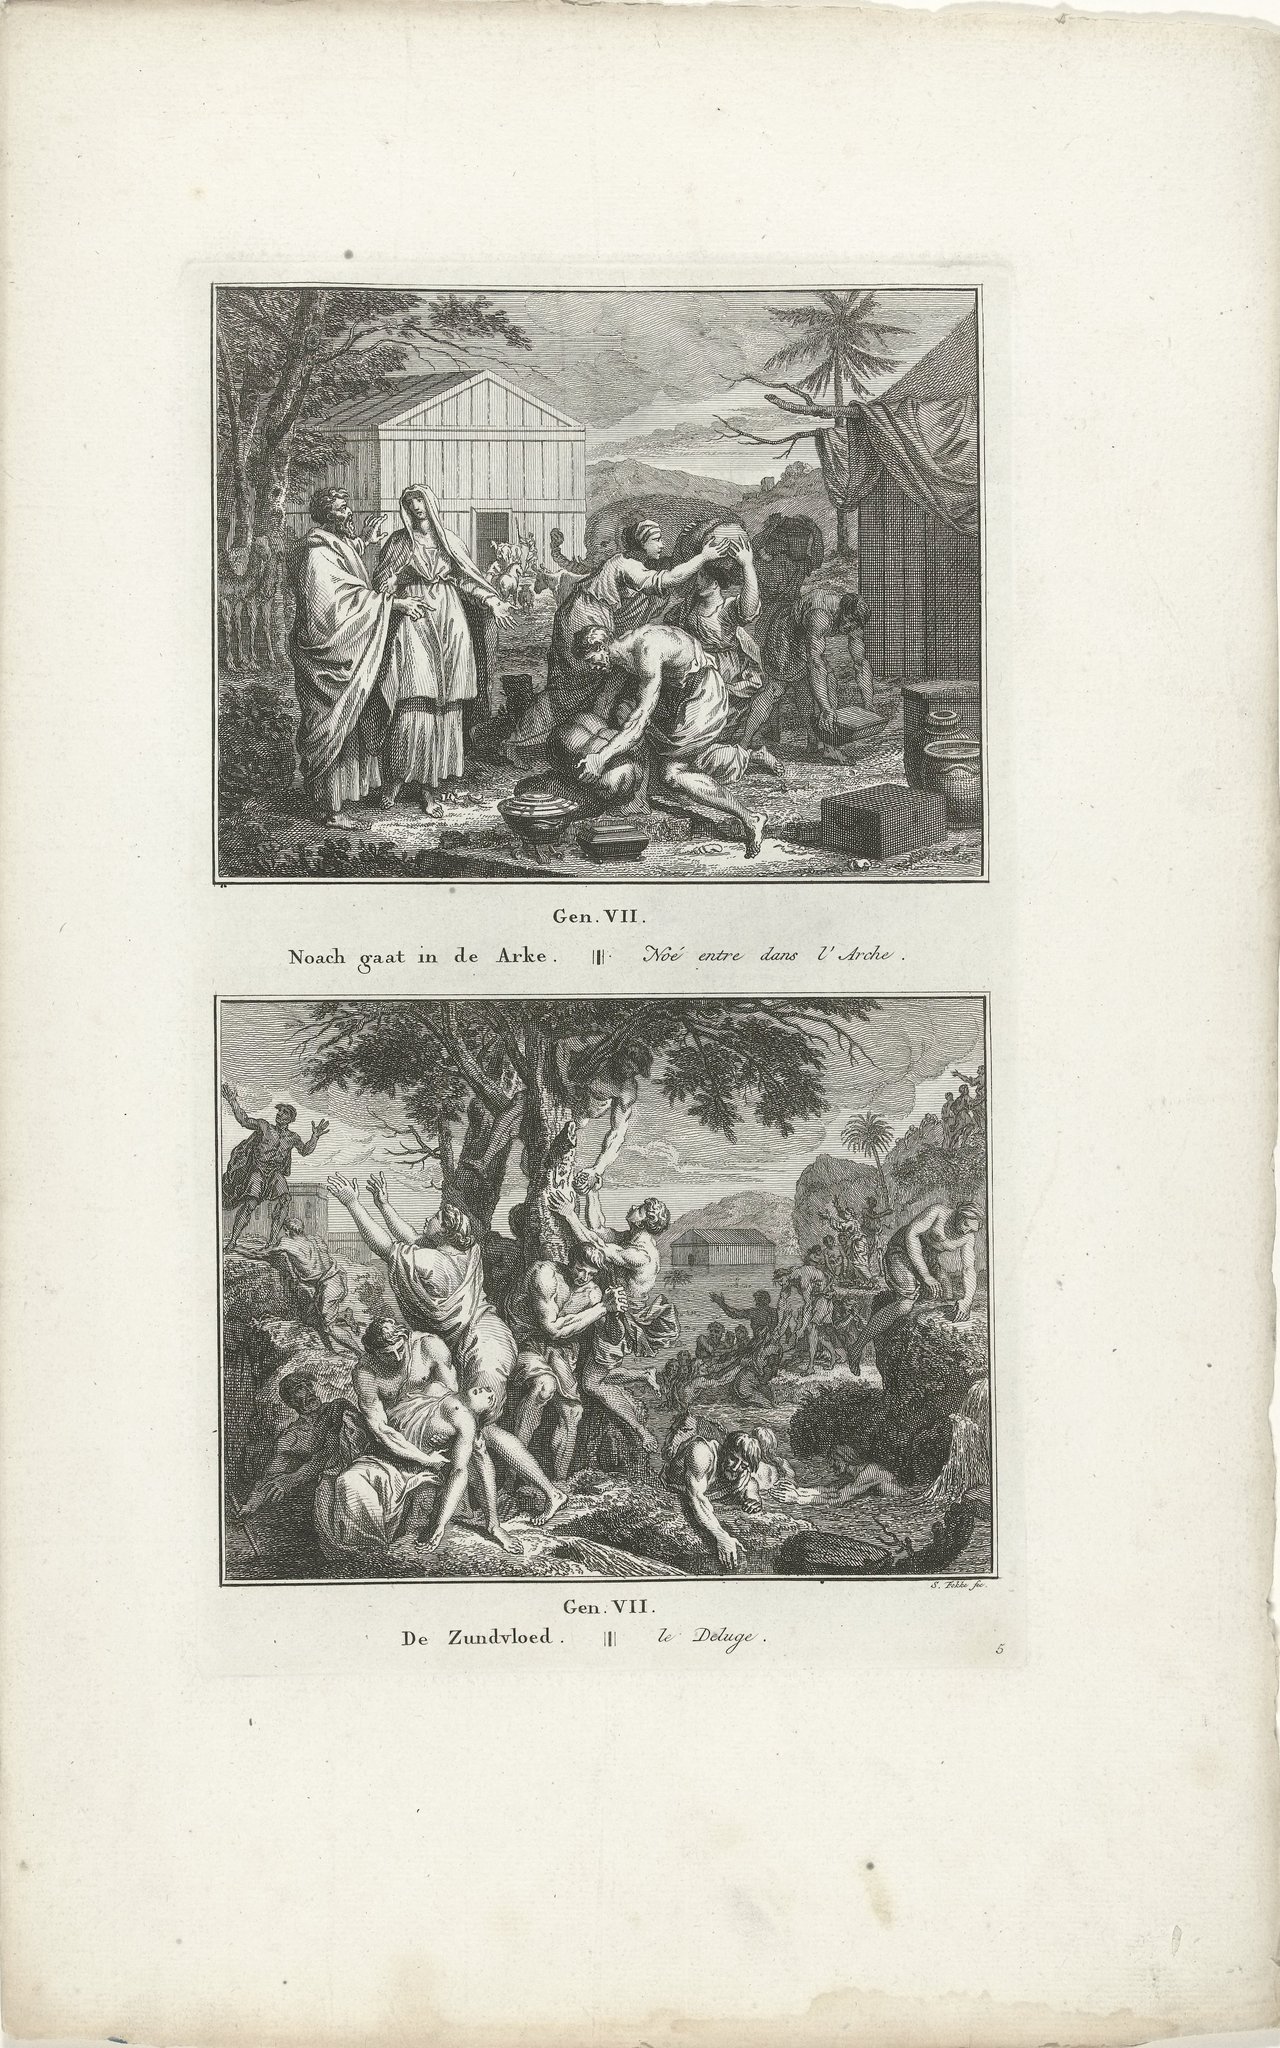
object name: print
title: Noach gaat in de arke / Noé entre dans l'Arche De Zundvloed / Le Deluge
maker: simon fokke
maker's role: draughtsman, print maker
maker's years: 1712-1784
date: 1791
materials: paper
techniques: etching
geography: amsterdam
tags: the flood and destruction of mankind ~ story of noah (genesis 7:10 - 8:17)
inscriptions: collector's mark: Lugt 2233, collector's mark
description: Twee Bijbelse voorstellingen uit Gen.7. Genummerd rechtsonder: 5.